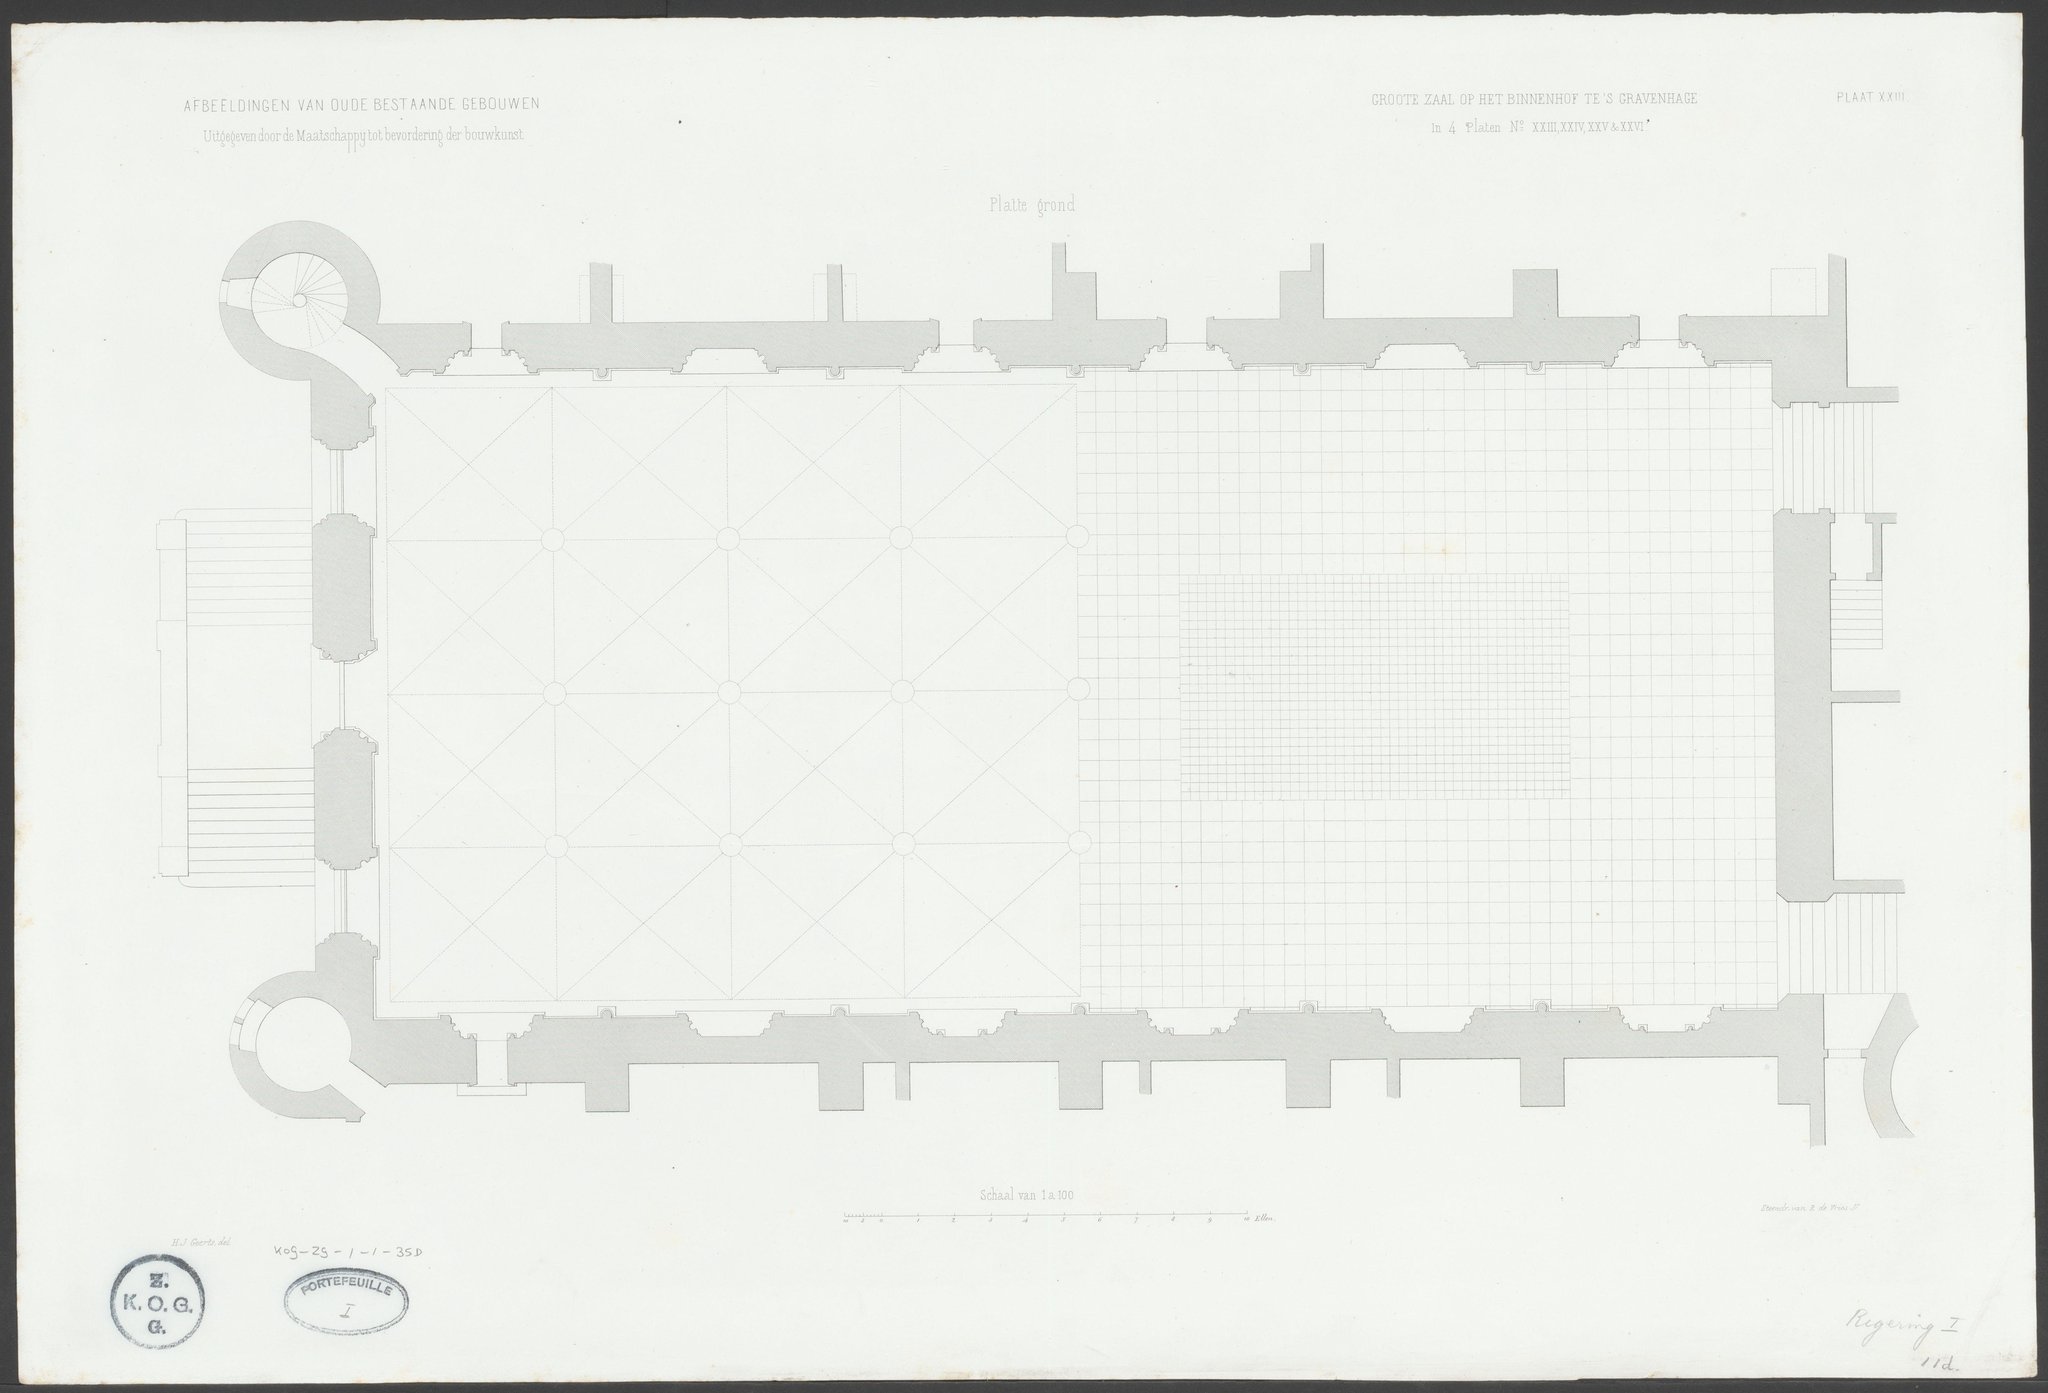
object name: print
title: Groote Zaal op het Binnenhof te 's Gravenhage in 4 Platen / Afbeeldingen van oude bestaande gebouwen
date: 1854-1874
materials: paper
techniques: lithograph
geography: netherlands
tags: representation of real building (either existing or having existed)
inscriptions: collector's mark, collector's mark: Lugt 1641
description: Plattegrond van de Ridderzaal, Binnenhof, Den Haag. Onderaan een schaalstok. Architectuurvoorstelling. Plaat XXIII. Onderwerpsrubrieken binnen de Atlas Zeden en Gewoonten: Regeering, Staten-Generaal.